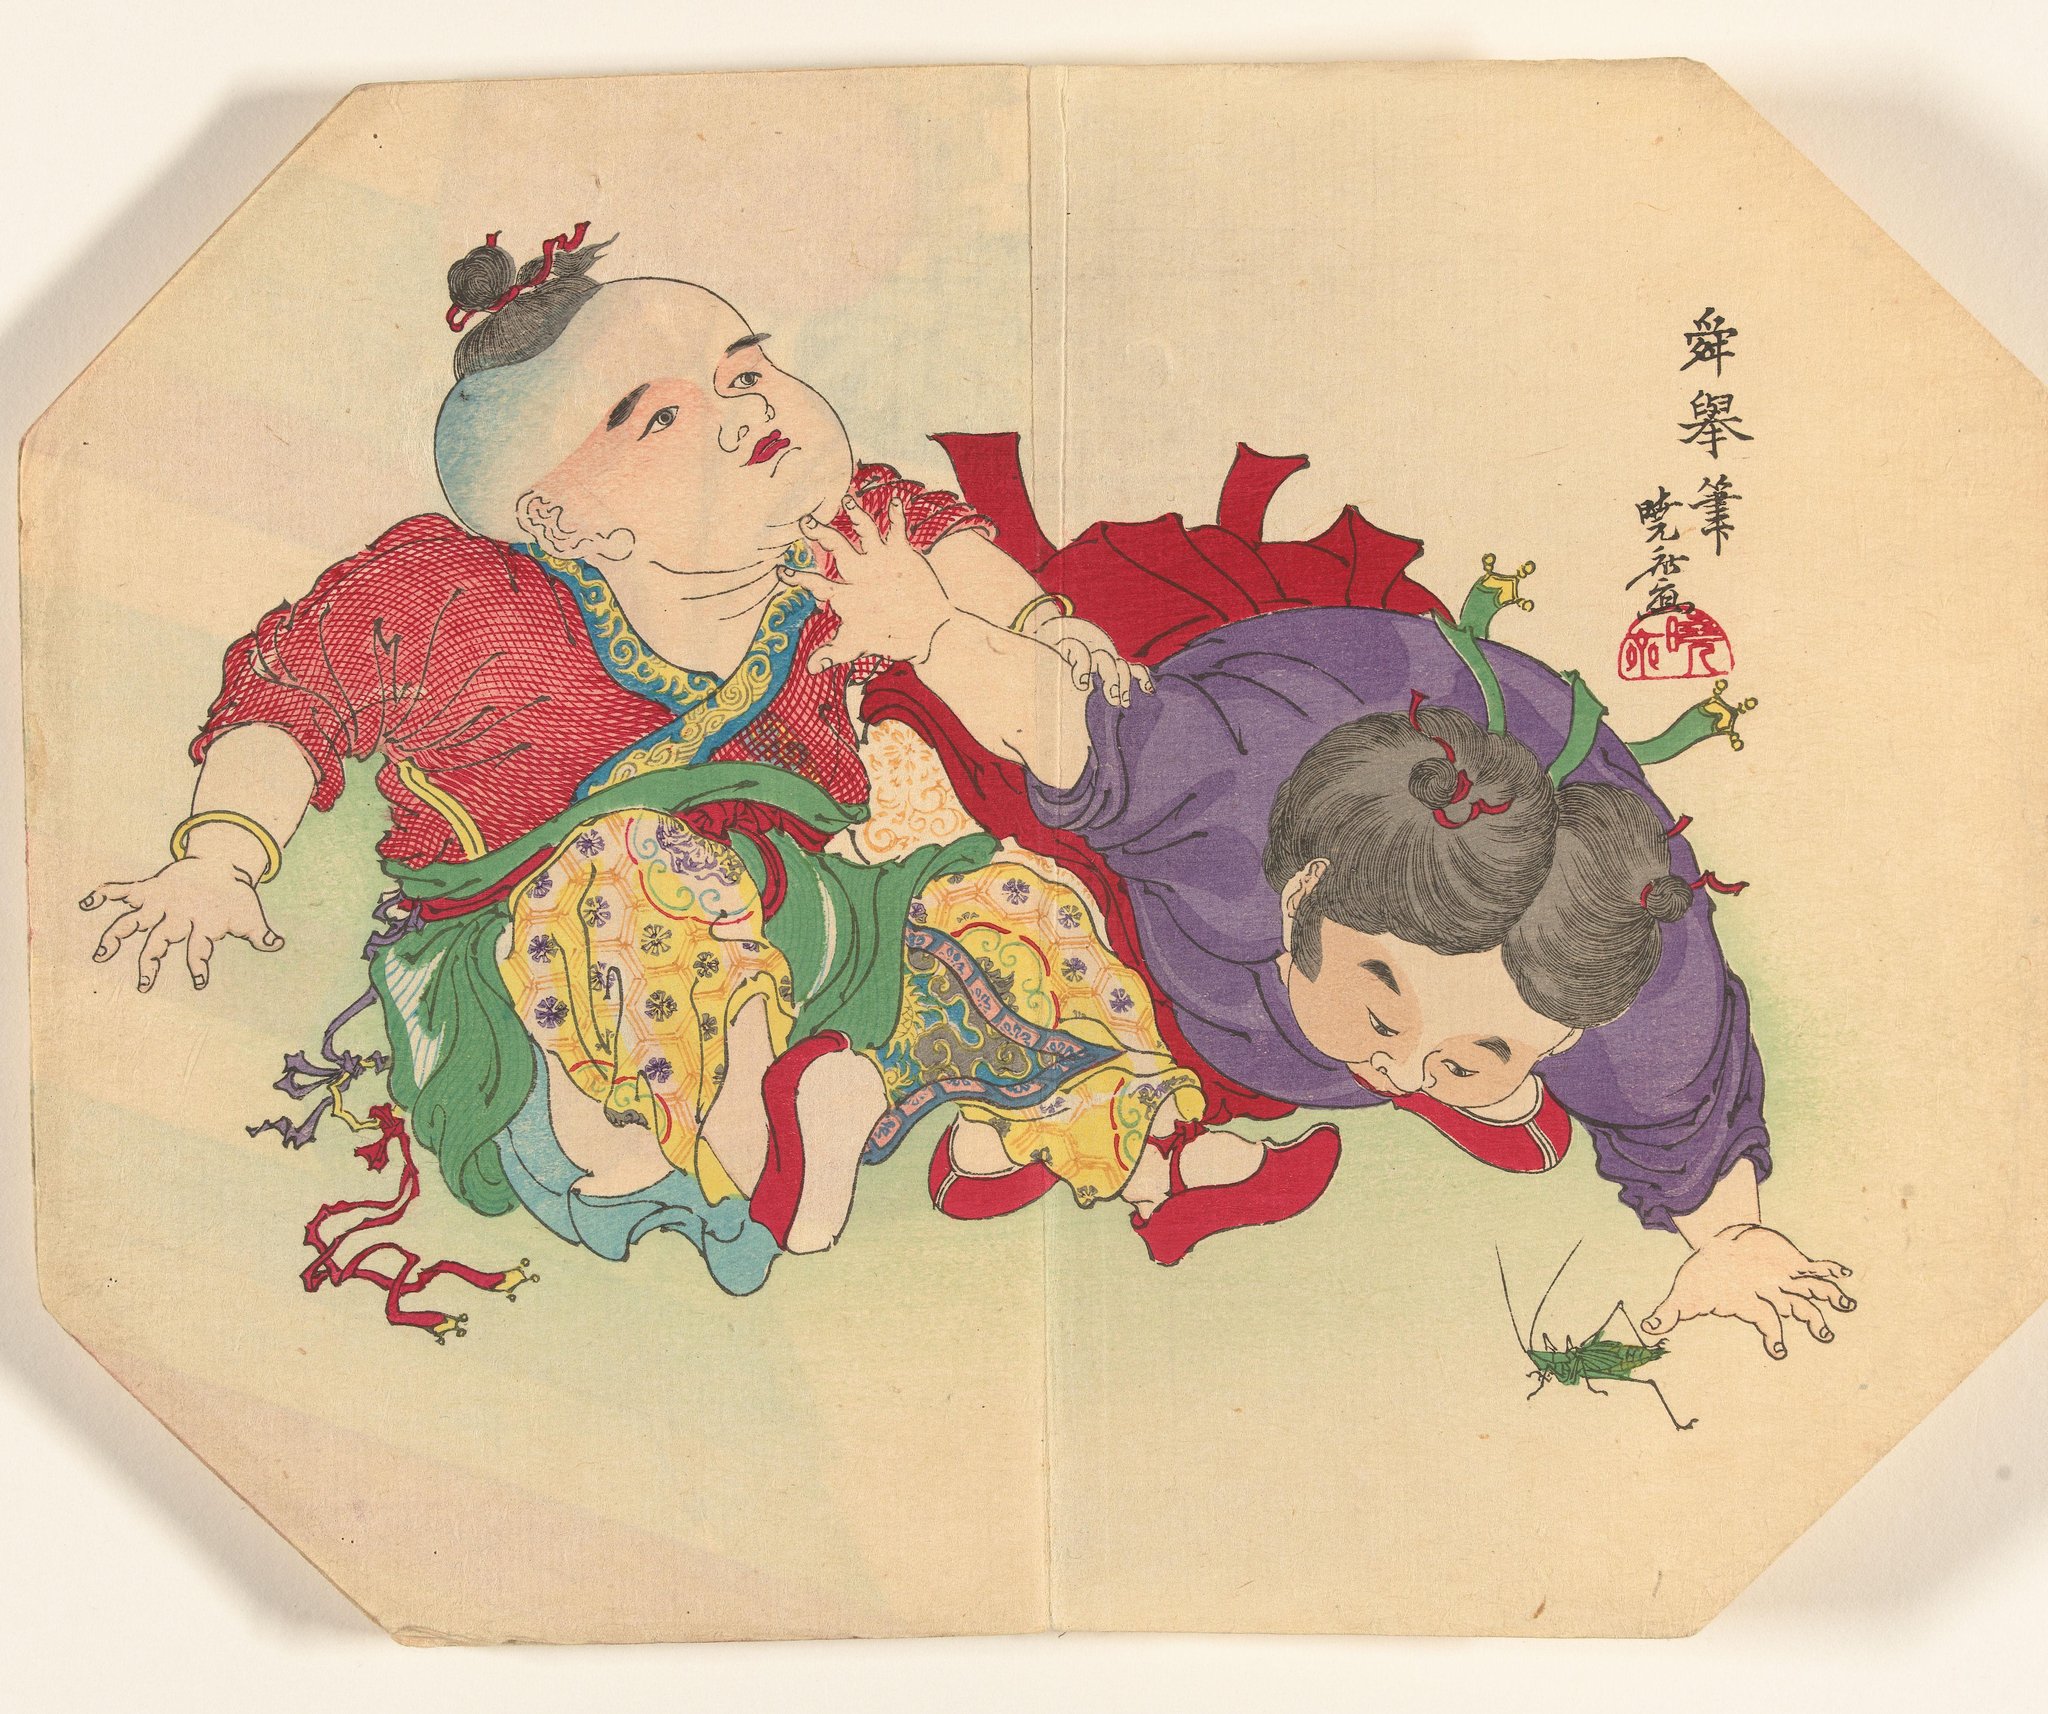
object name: album leaf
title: Twee kinderen kijkend naar sprinkhaan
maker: kawanabe kyôsai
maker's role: draughtsman, print maker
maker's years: 1831-1889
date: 1880-1890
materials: paper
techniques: woodcut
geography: japan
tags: child (+ two persons), insects: grass-hopper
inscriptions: collector's mark: Lugt 2228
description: Octogonale prent in album met 39 prenten.